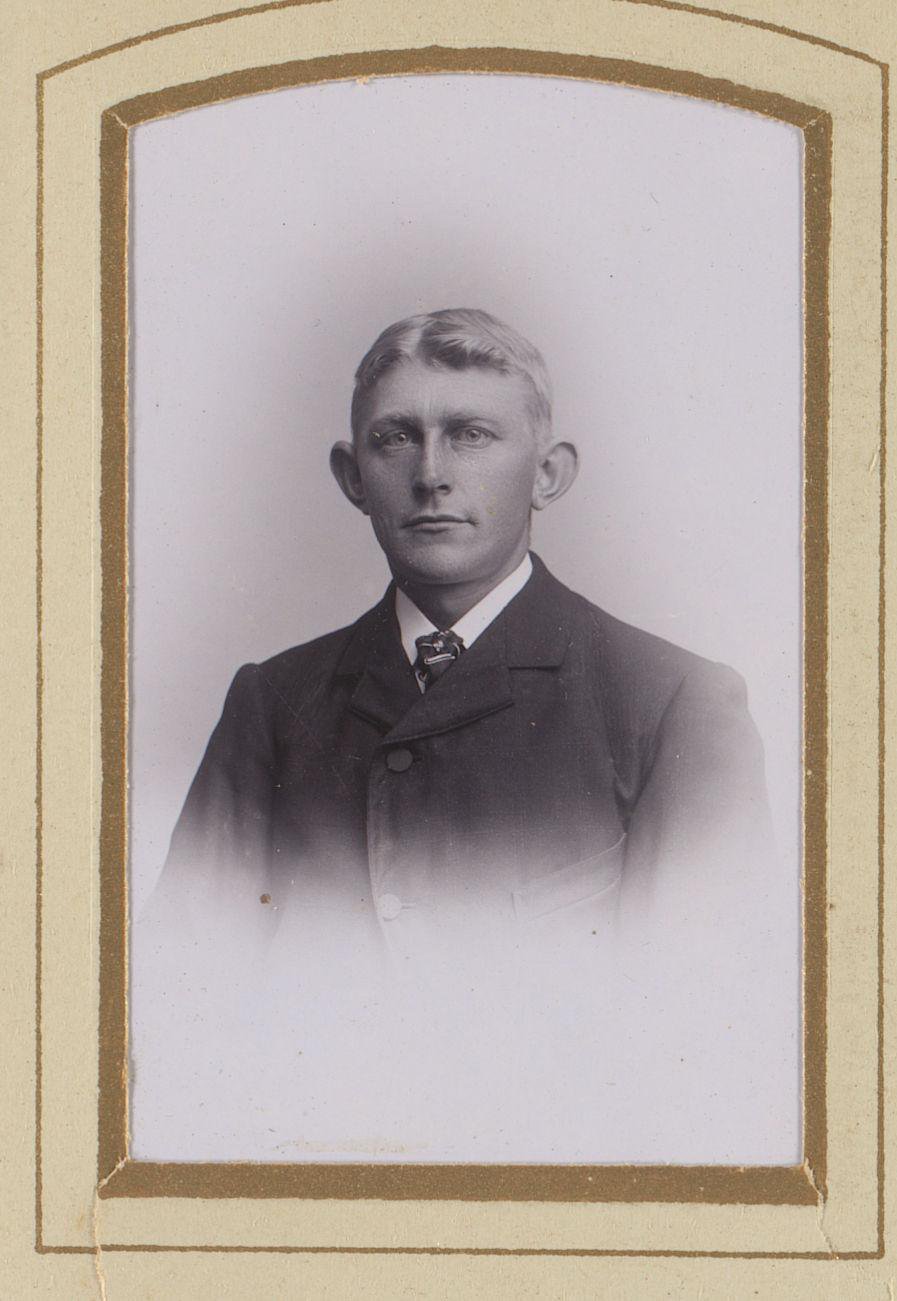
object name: carte de visite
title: Portret van een man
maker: johannes laurens theodorus huijsen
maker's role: fotograaf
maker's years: 1852-1910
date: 1883-1910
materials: cardboard, photographic support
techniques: collodion silver print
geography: hoorn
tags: historical persons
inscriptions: inscription: ‘J.L.T. HUIJSEN/ Photographe/ Bekroond op verschillende/ Tentoonstellingen./ HOORN/ Ramen 17./ De plaat blijft ter nabestelling bewaard.’